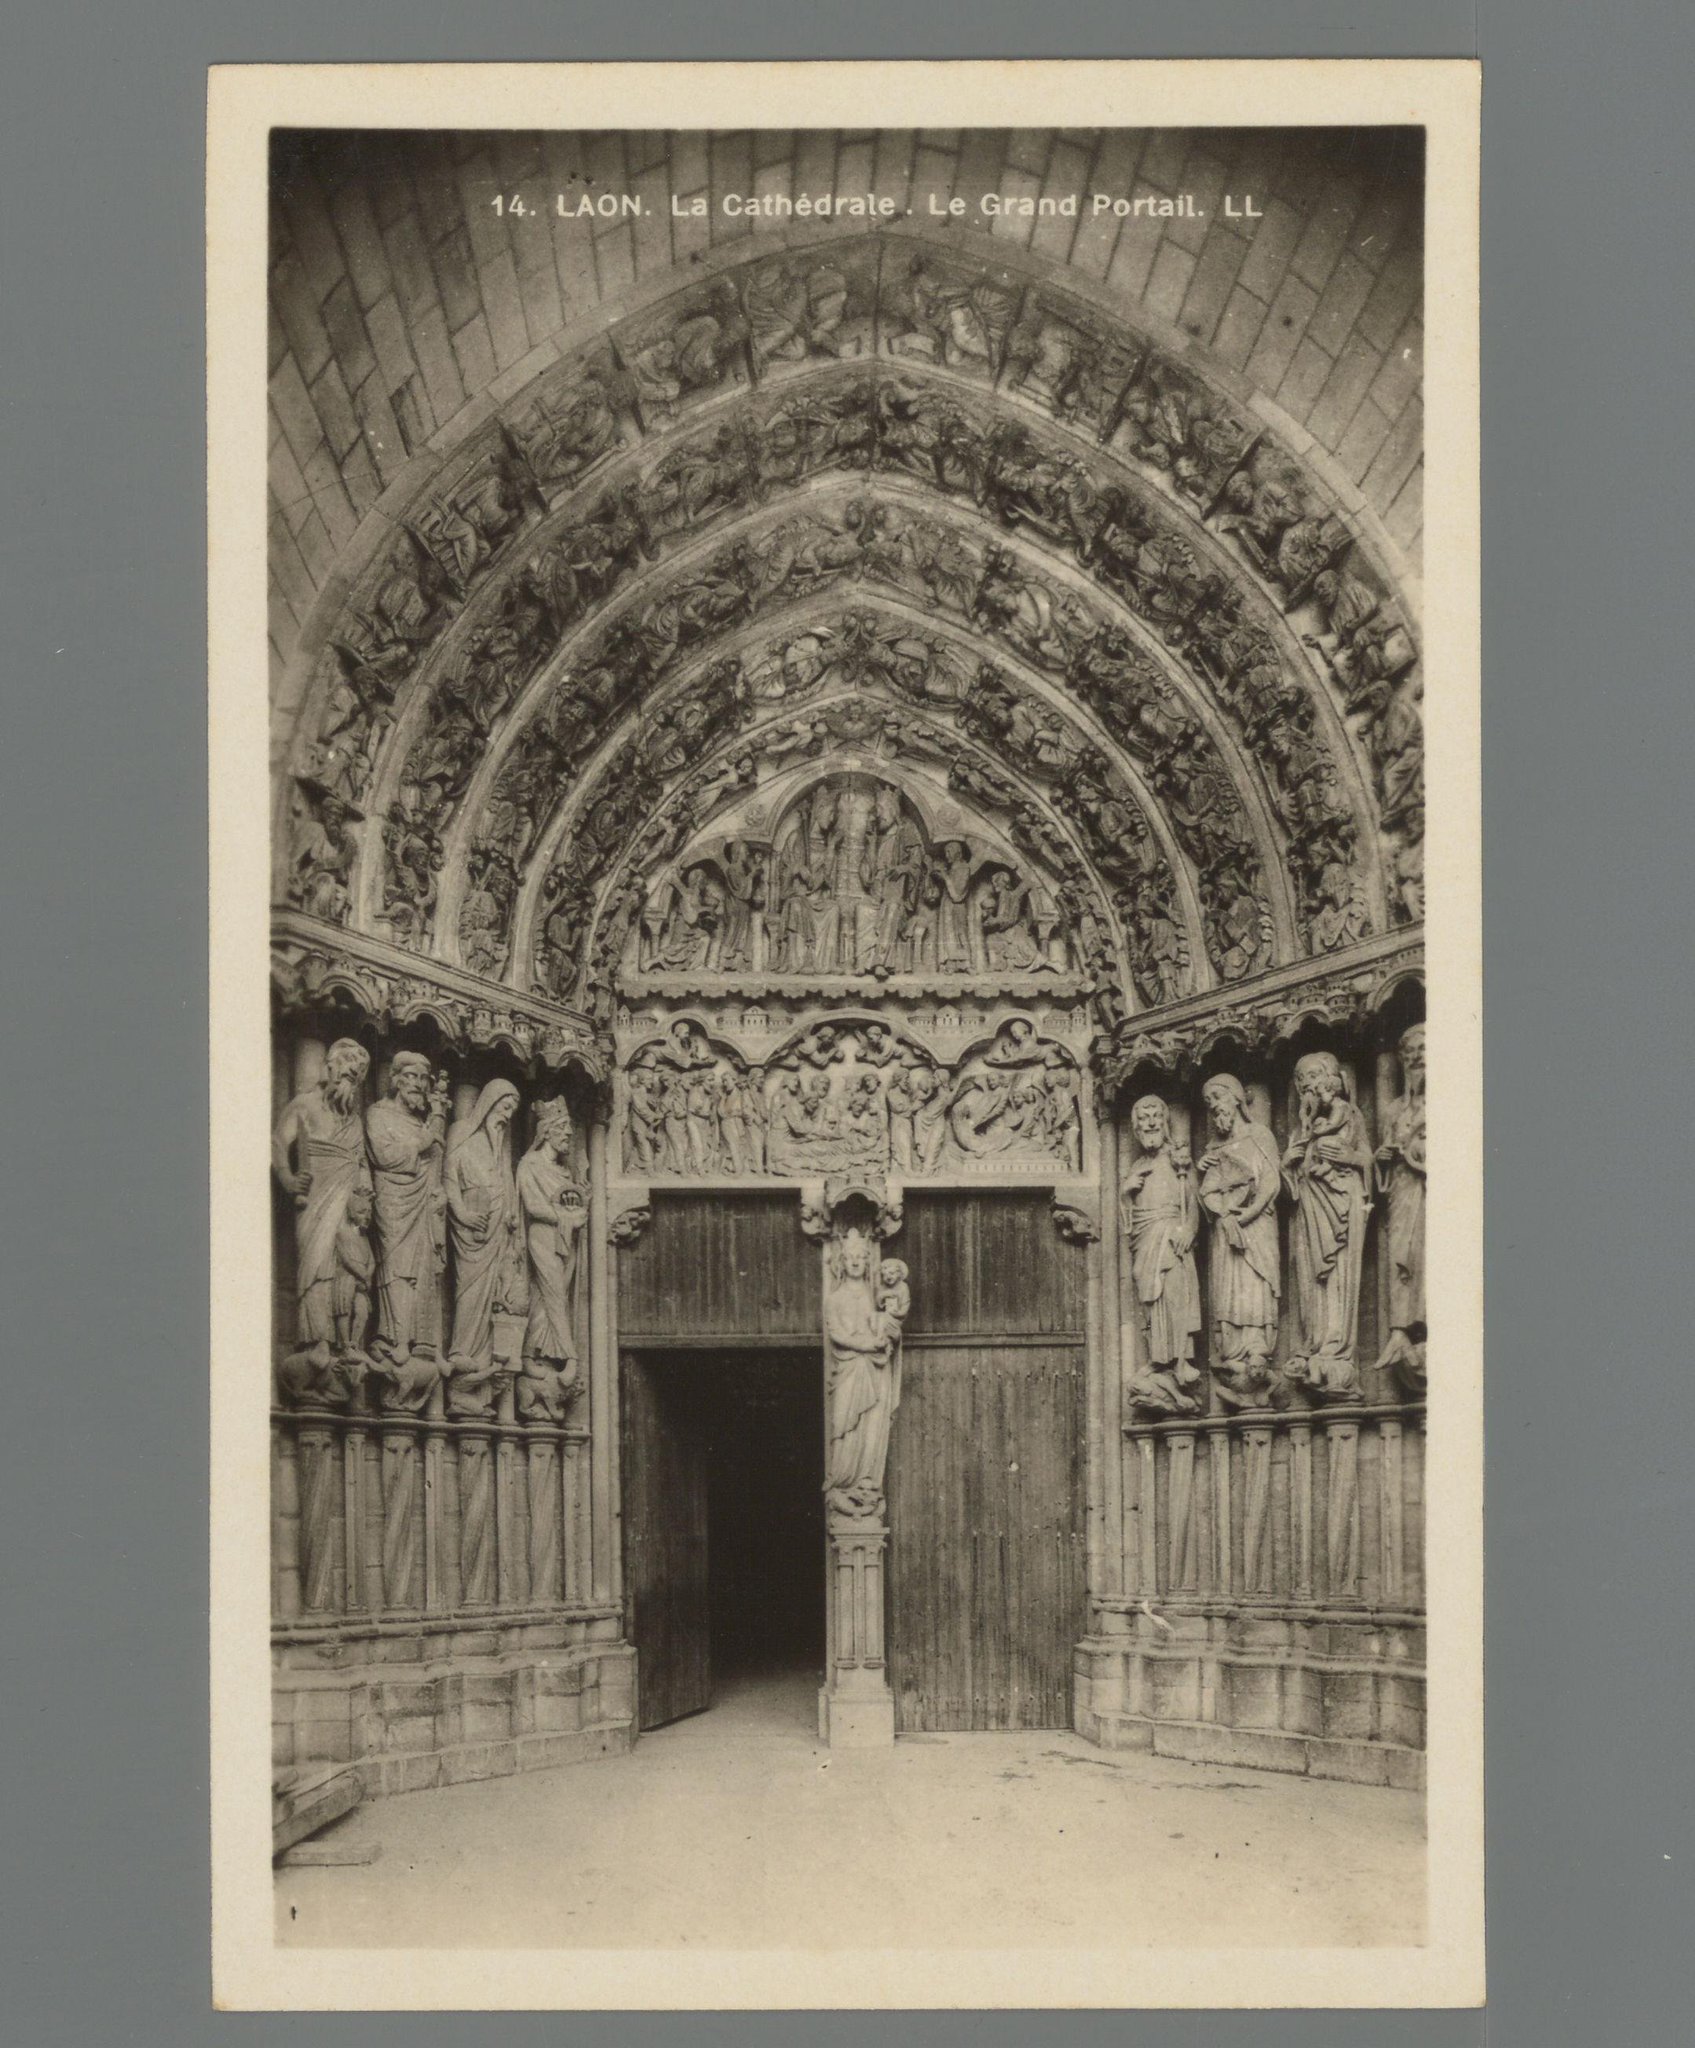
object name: ansichtkaart, prentbriefkaart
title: Laon. La Cathédrale. Le Grand Portail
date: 1920-1932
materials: photographic support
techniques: photography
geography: paris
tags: parts of church exterior and annexes: portal